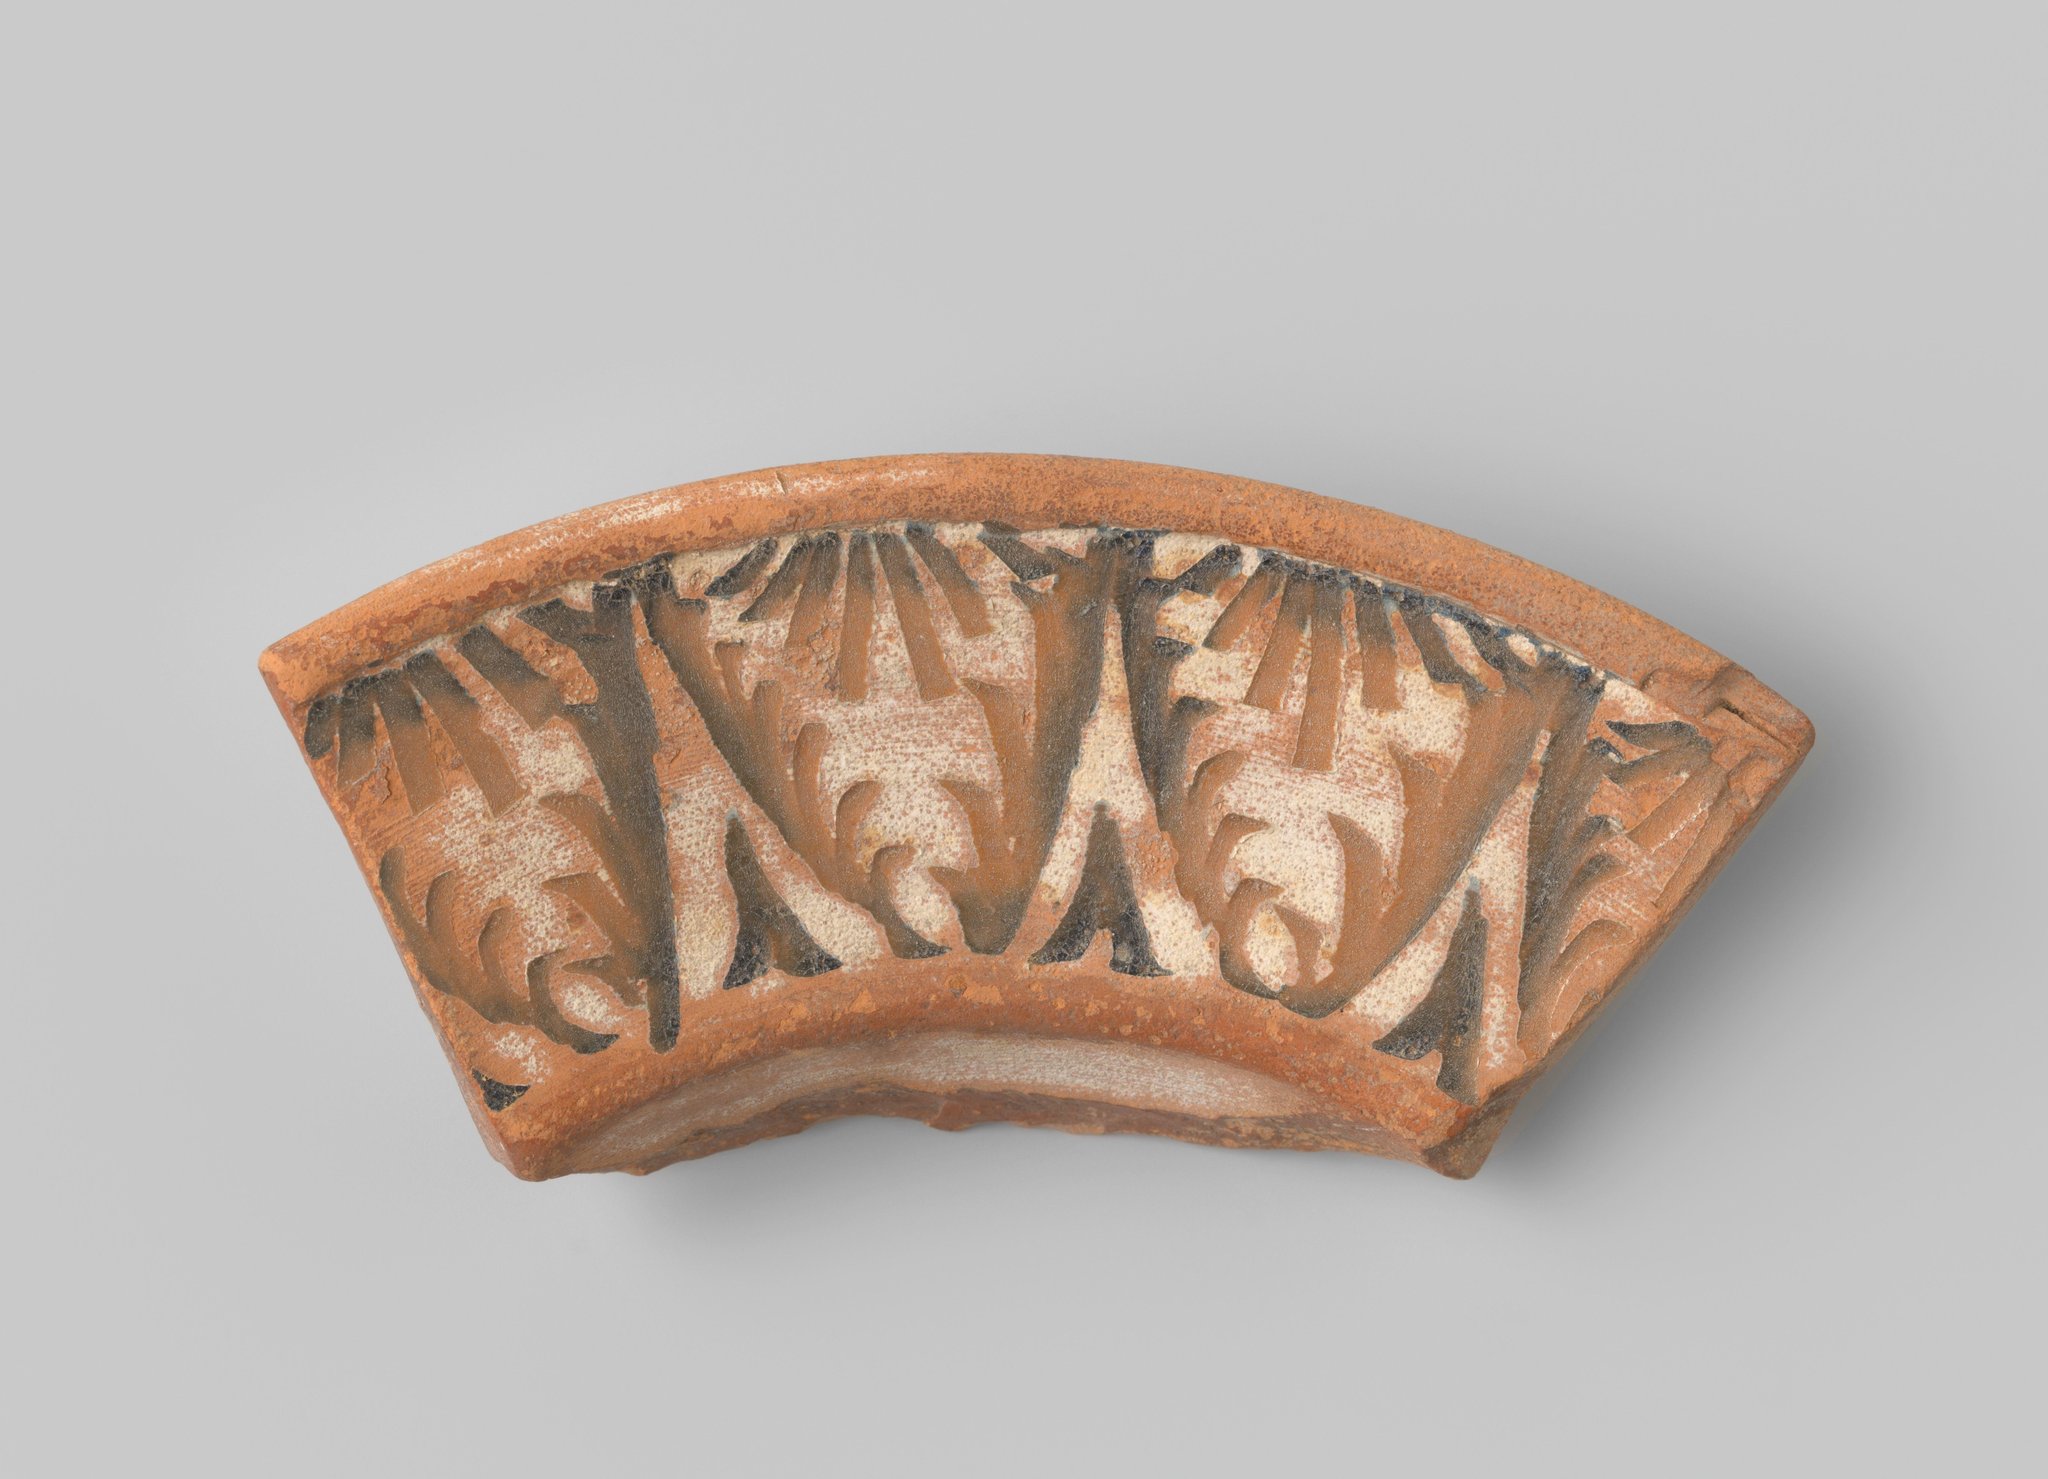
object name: sherd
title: Fragment van een schotel met roodbakkende scherf, met aan de voor- en achterzijde wit glazuur, waarop aan de voorzijde in sgrafitto-techniek met zwart glazuur driehoeken zijn aangebracht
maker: Anonymous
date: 1200-1899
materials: earthenware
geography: italy